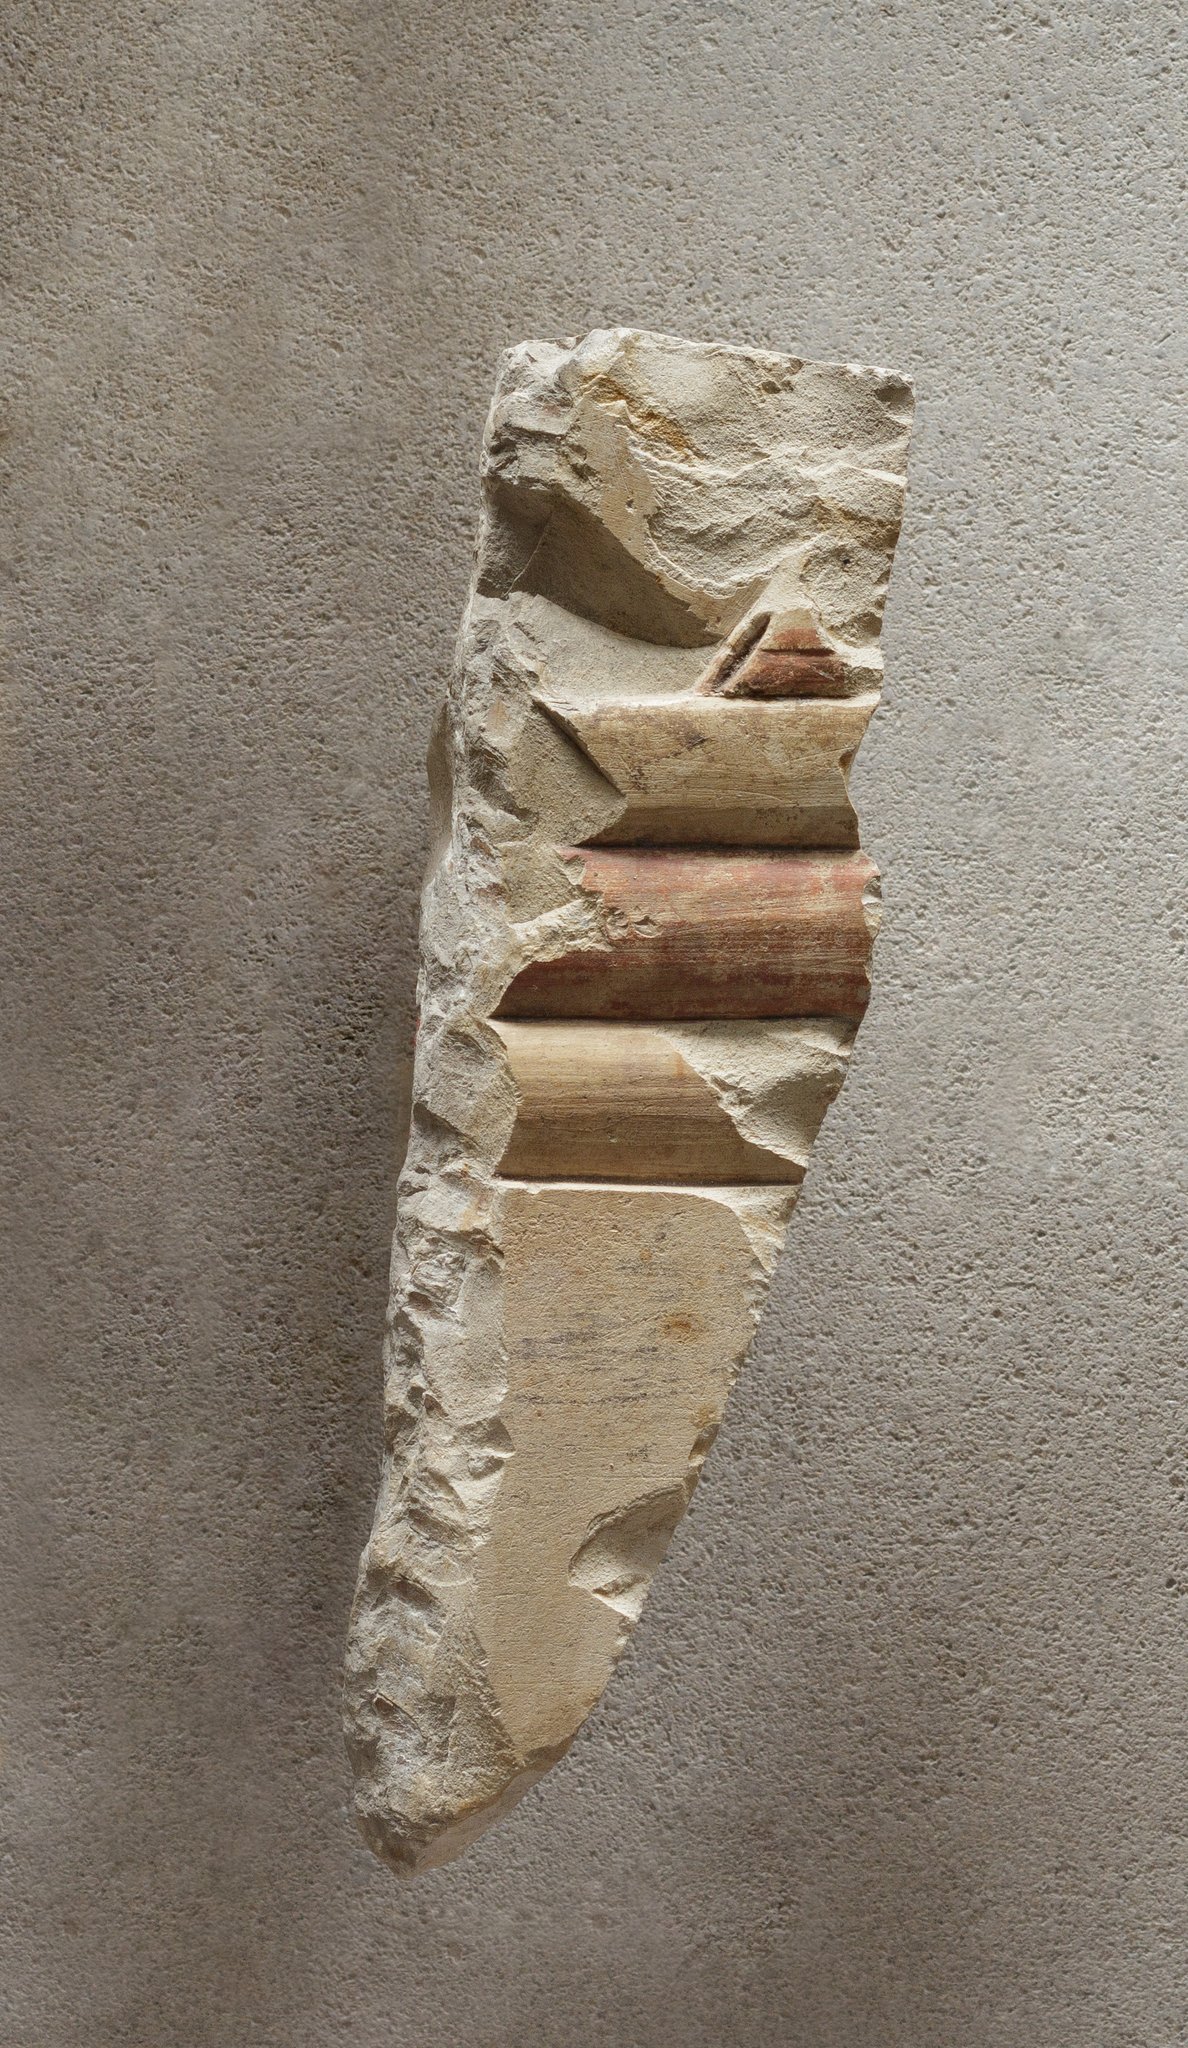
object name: relief, foot of ox, neferu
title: Relief of the foot of an ox- see 26.3.353-3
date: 2051-2030 BCE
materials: limestone, paint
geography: egypt